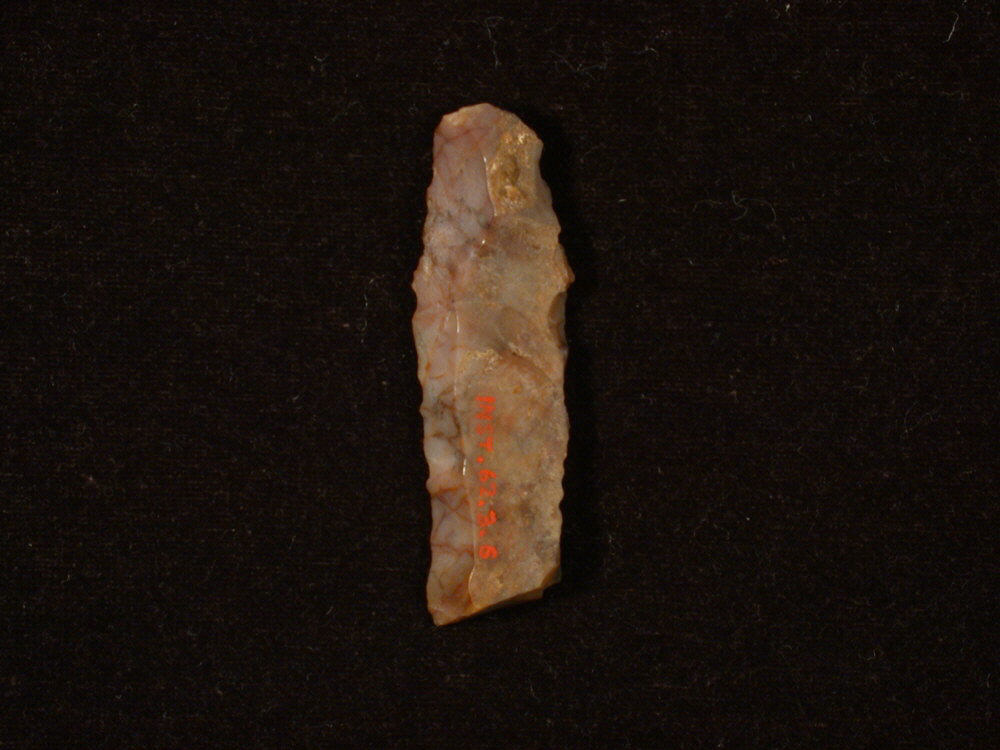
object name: knife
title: Blade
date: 5000-4001 BCE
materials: stone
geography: iran